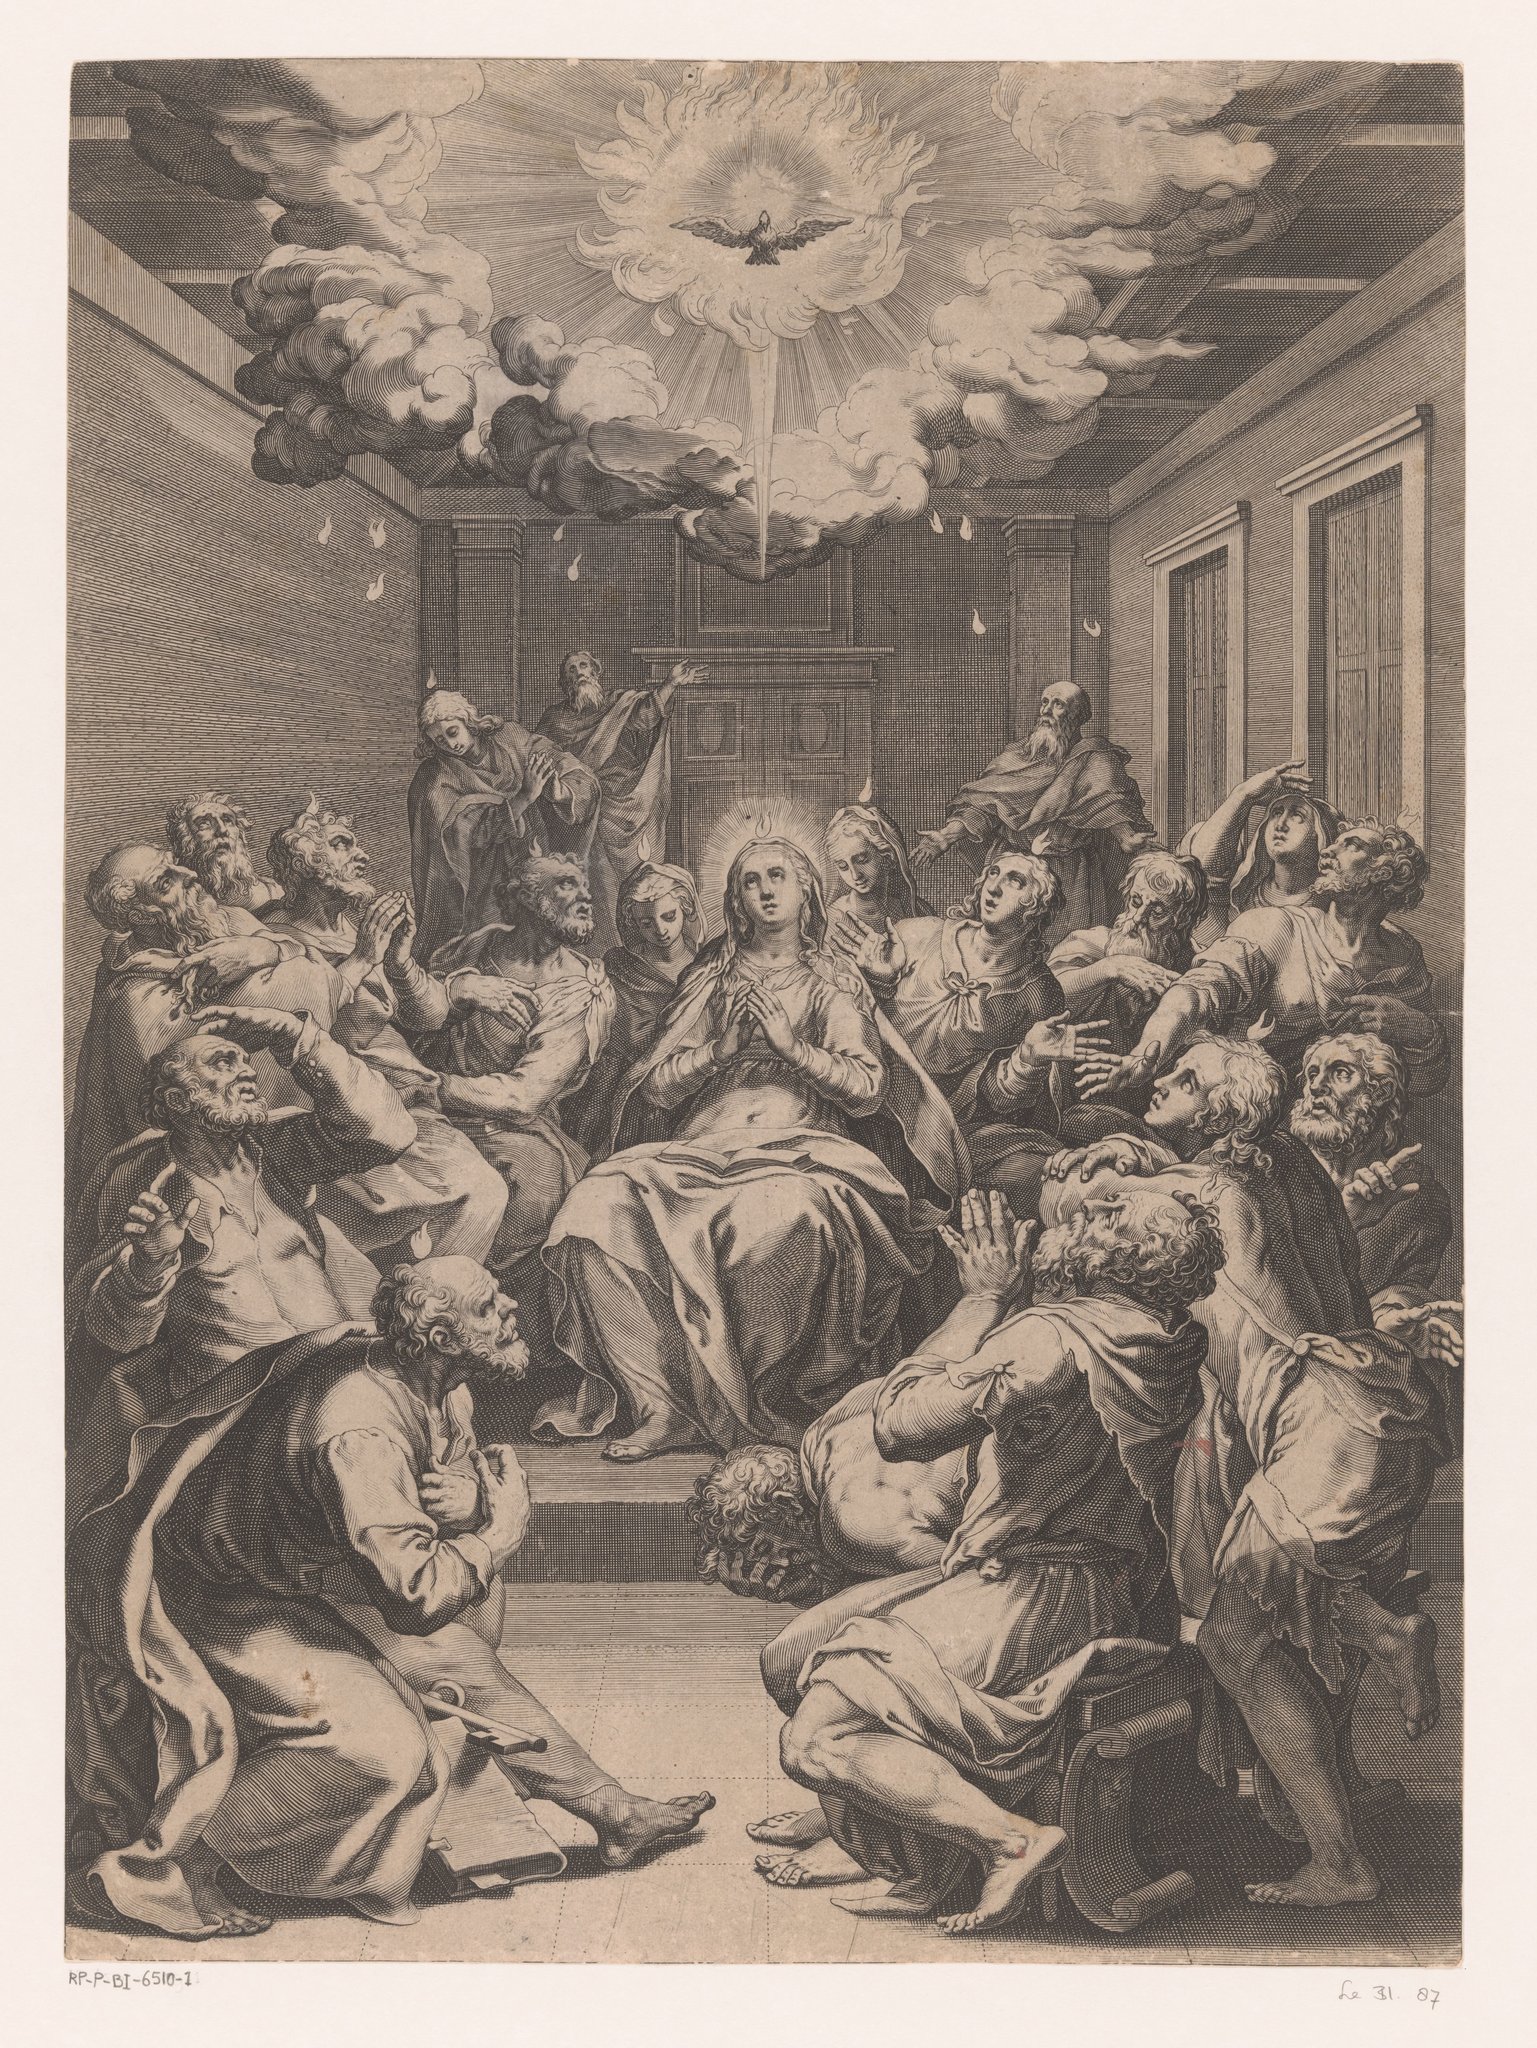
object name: print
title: Uitstorting van de Heilige Geest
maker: j. michel pelais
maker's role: print maker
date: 1620-1630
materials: paper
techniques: engraving, etching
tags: holy ghost represented as flames, pentecost: the holy ghost descends upon (mary and) the apostles, sometimes paul and/or representatives of the nations present (acts 2:1-4), holy ghost represented as a dove (in flames)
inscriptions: collector's mark: Lugt 240